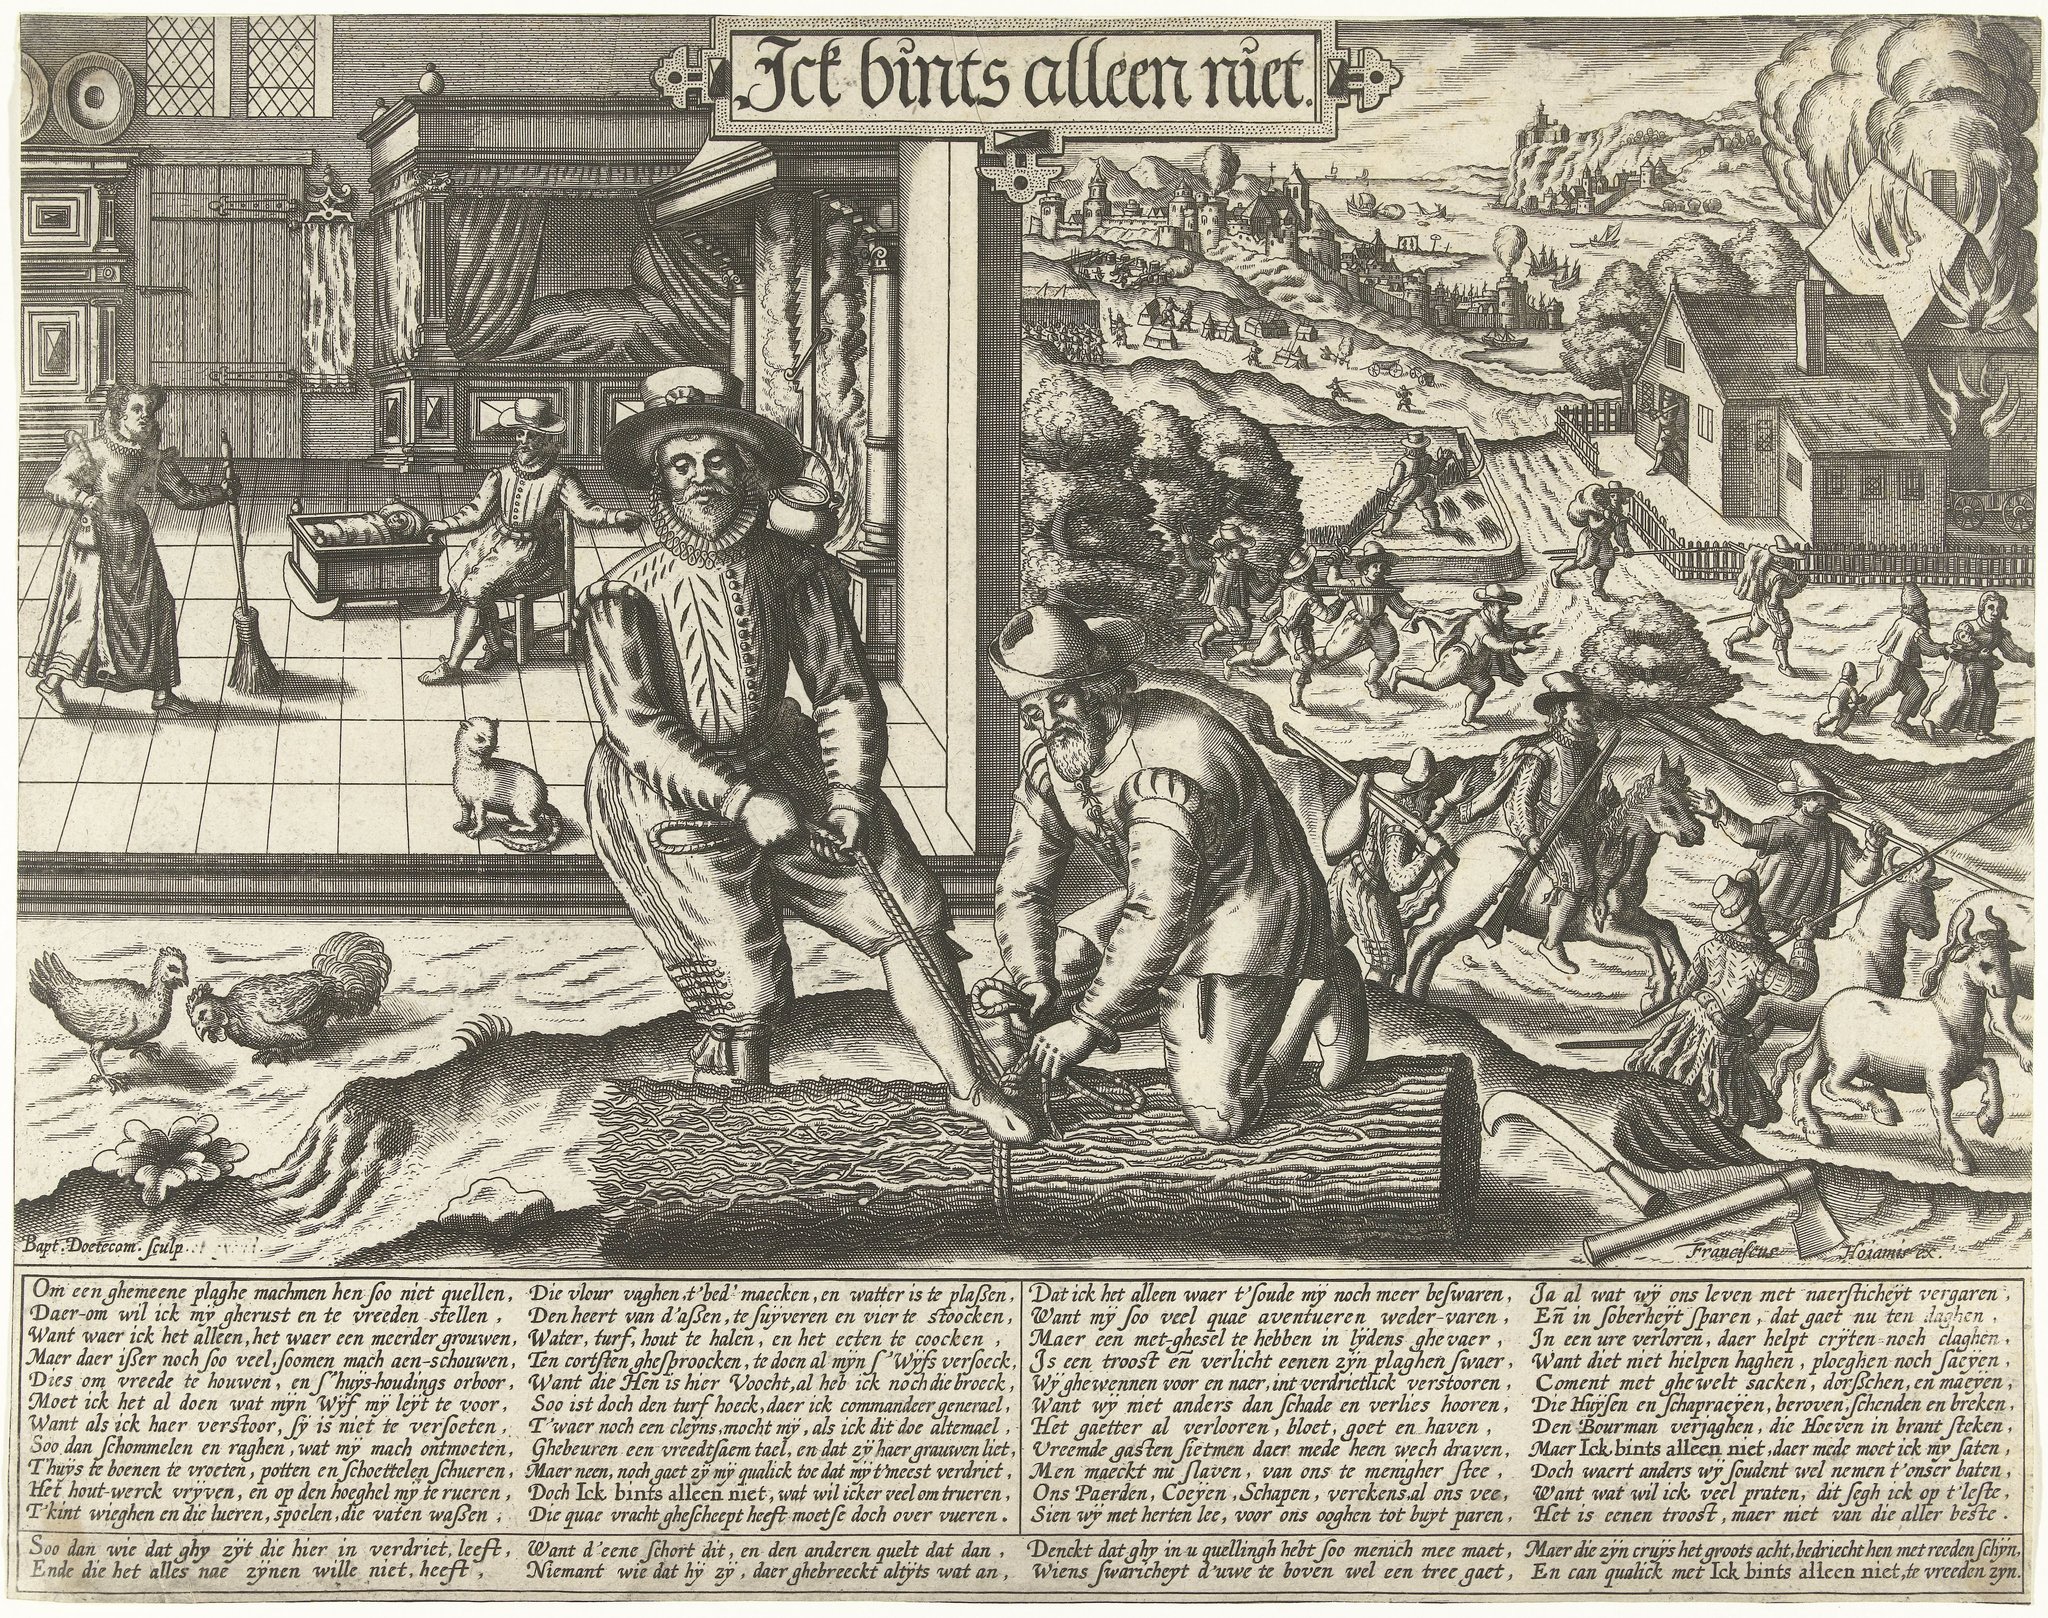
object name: print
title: Spreekwoord: Ick bints alleen niet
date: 1601-1605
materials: paper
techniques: engraving, etching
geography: amsterdam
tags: proverbs, sayings, etc., setting on fire (of conquered city), man doing woman's work, political refugee, 'émigré'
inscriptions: collector's mark: Lugt 2228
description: Op den voorgrond binden twee mannen een takkenbos. Links een huiskamer met een man en een vrouw. De vrouw vertelt de man wat hij moet doen en laten. Rechts een door oorlog geteisterd dorp met een brandende boerderij, soldaten en vluchtelingen. Onder de voorstelling een Nederlands verklarend vers over gedeeld leed.